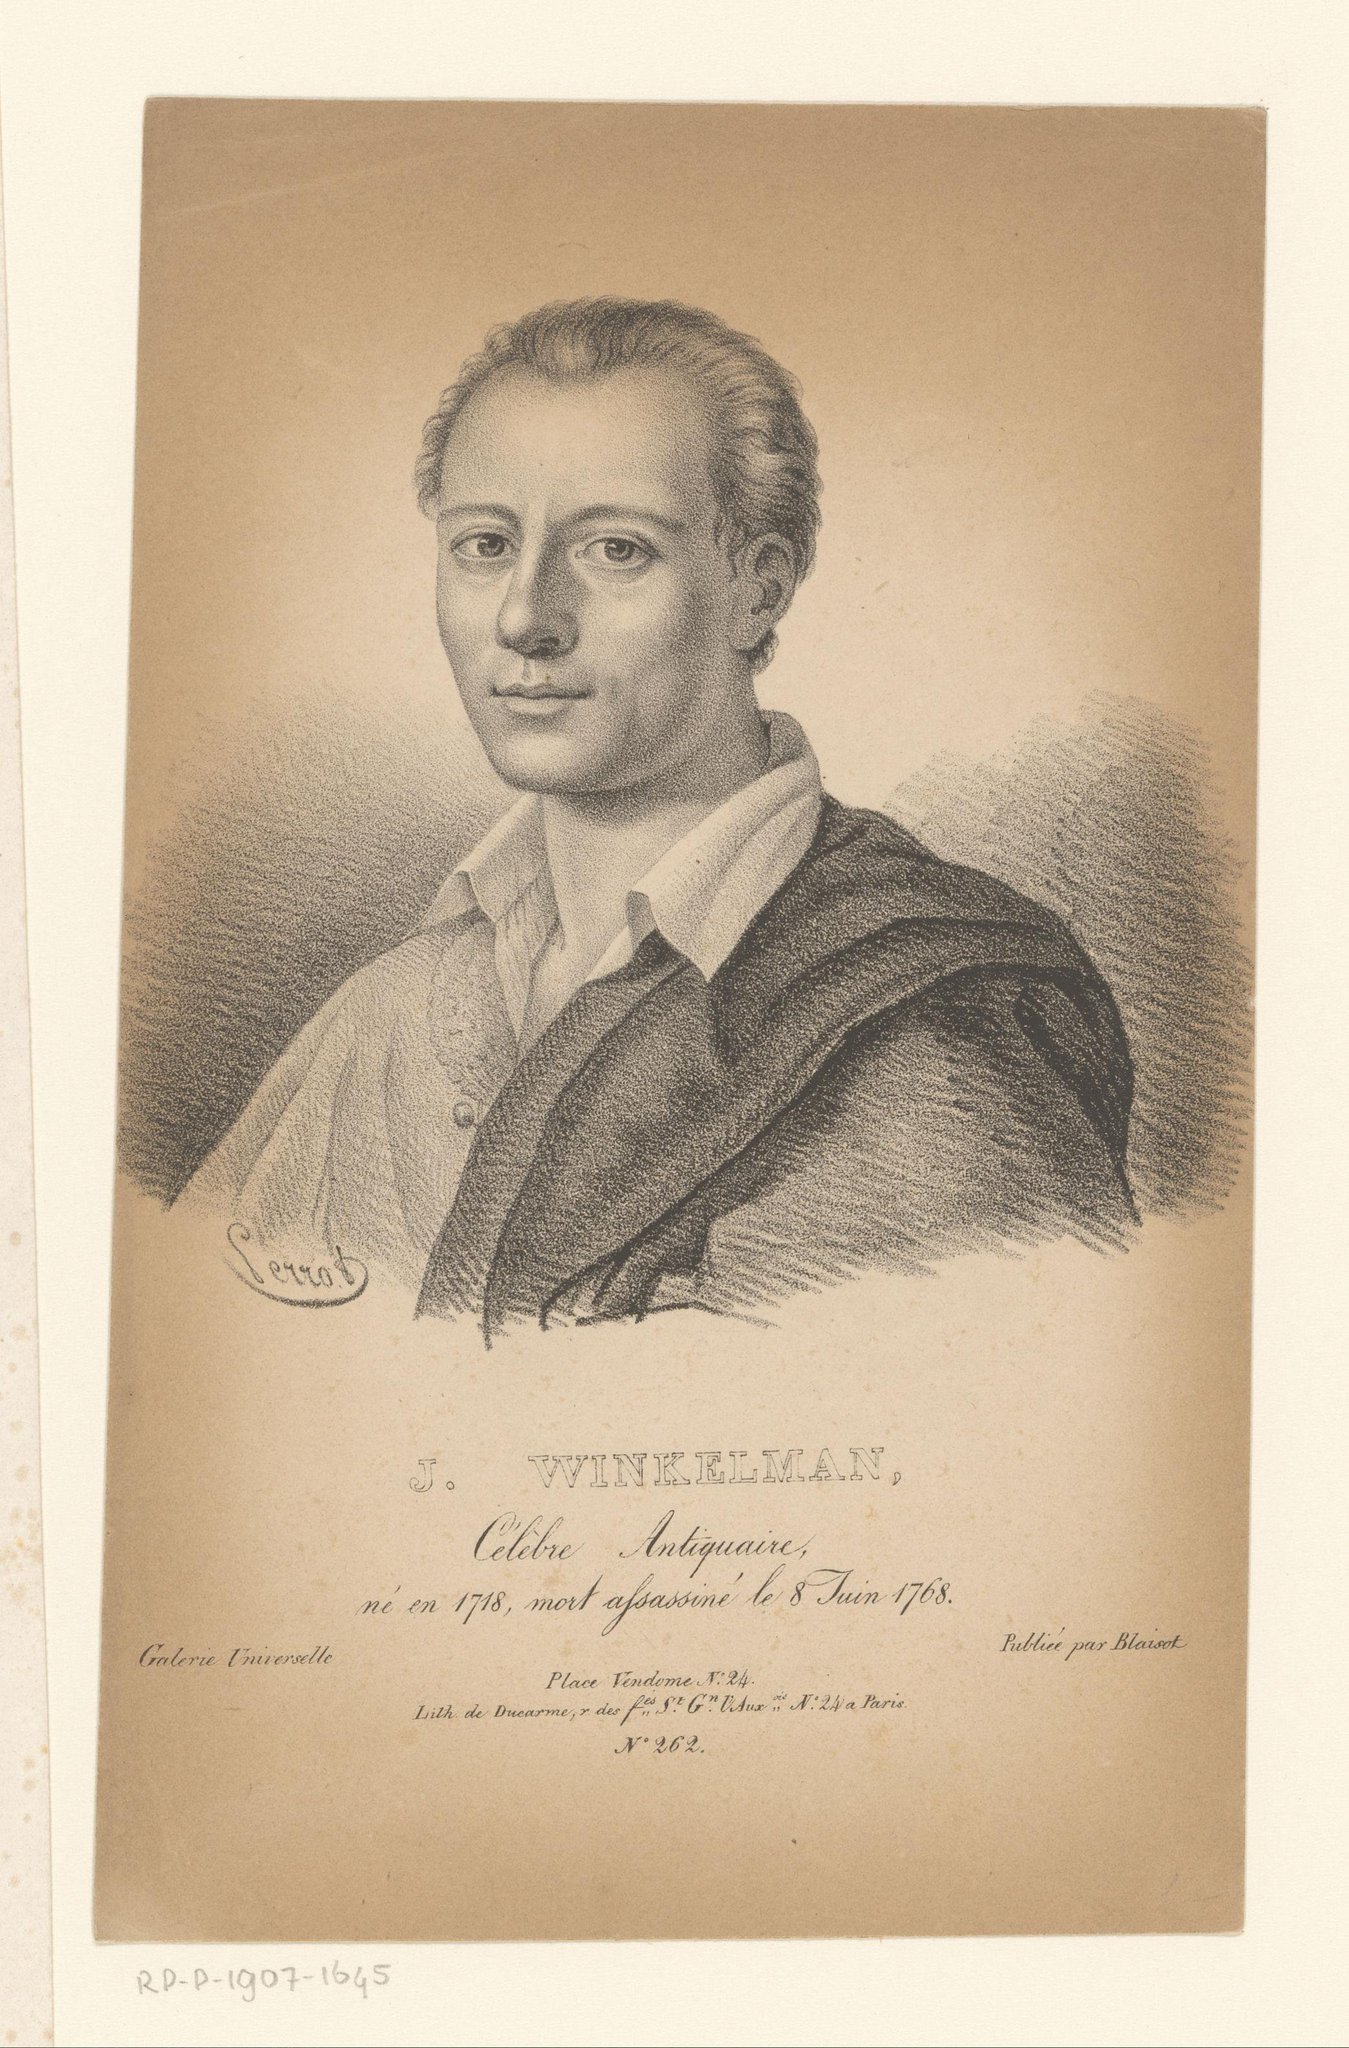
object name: print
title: Galerie universelle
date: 1820-1829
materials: paper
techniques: lithograph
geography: paris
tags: history and archaeology, historical persons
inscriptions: collector's mark: Lugt 2228